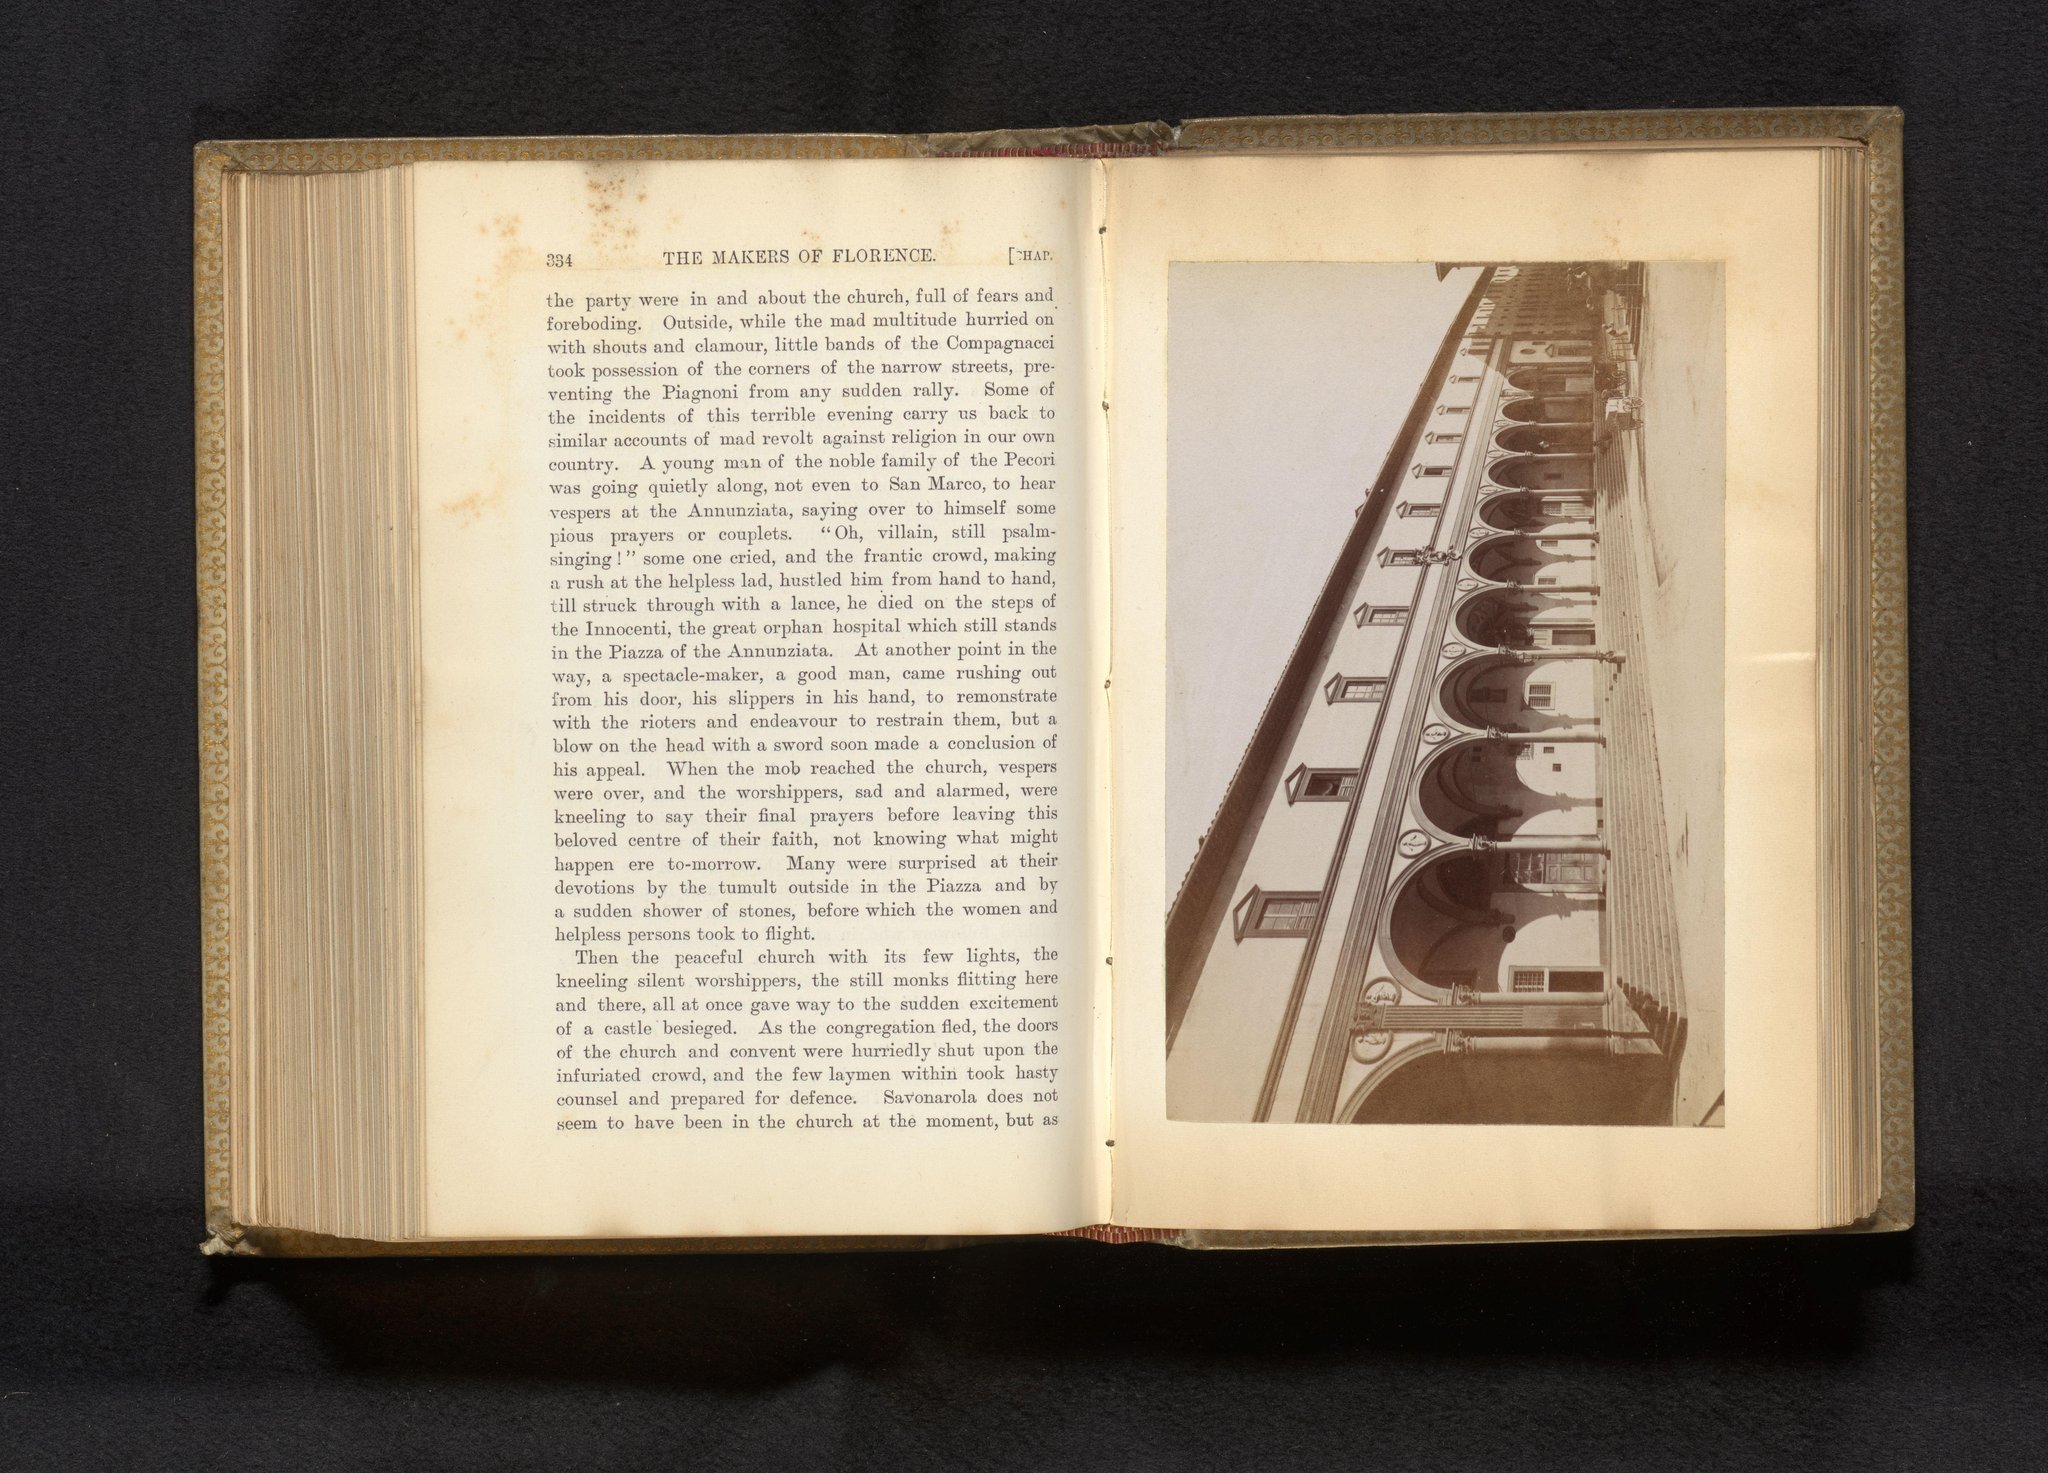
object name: photograph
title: Exterieur van het Ospedale degli Innocenti te Florence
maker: Anonymous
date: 1878-1888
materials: photographic support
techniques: albumen print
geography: florence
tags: foundling-hospital, façade (of house or building), arcade ~ architecture